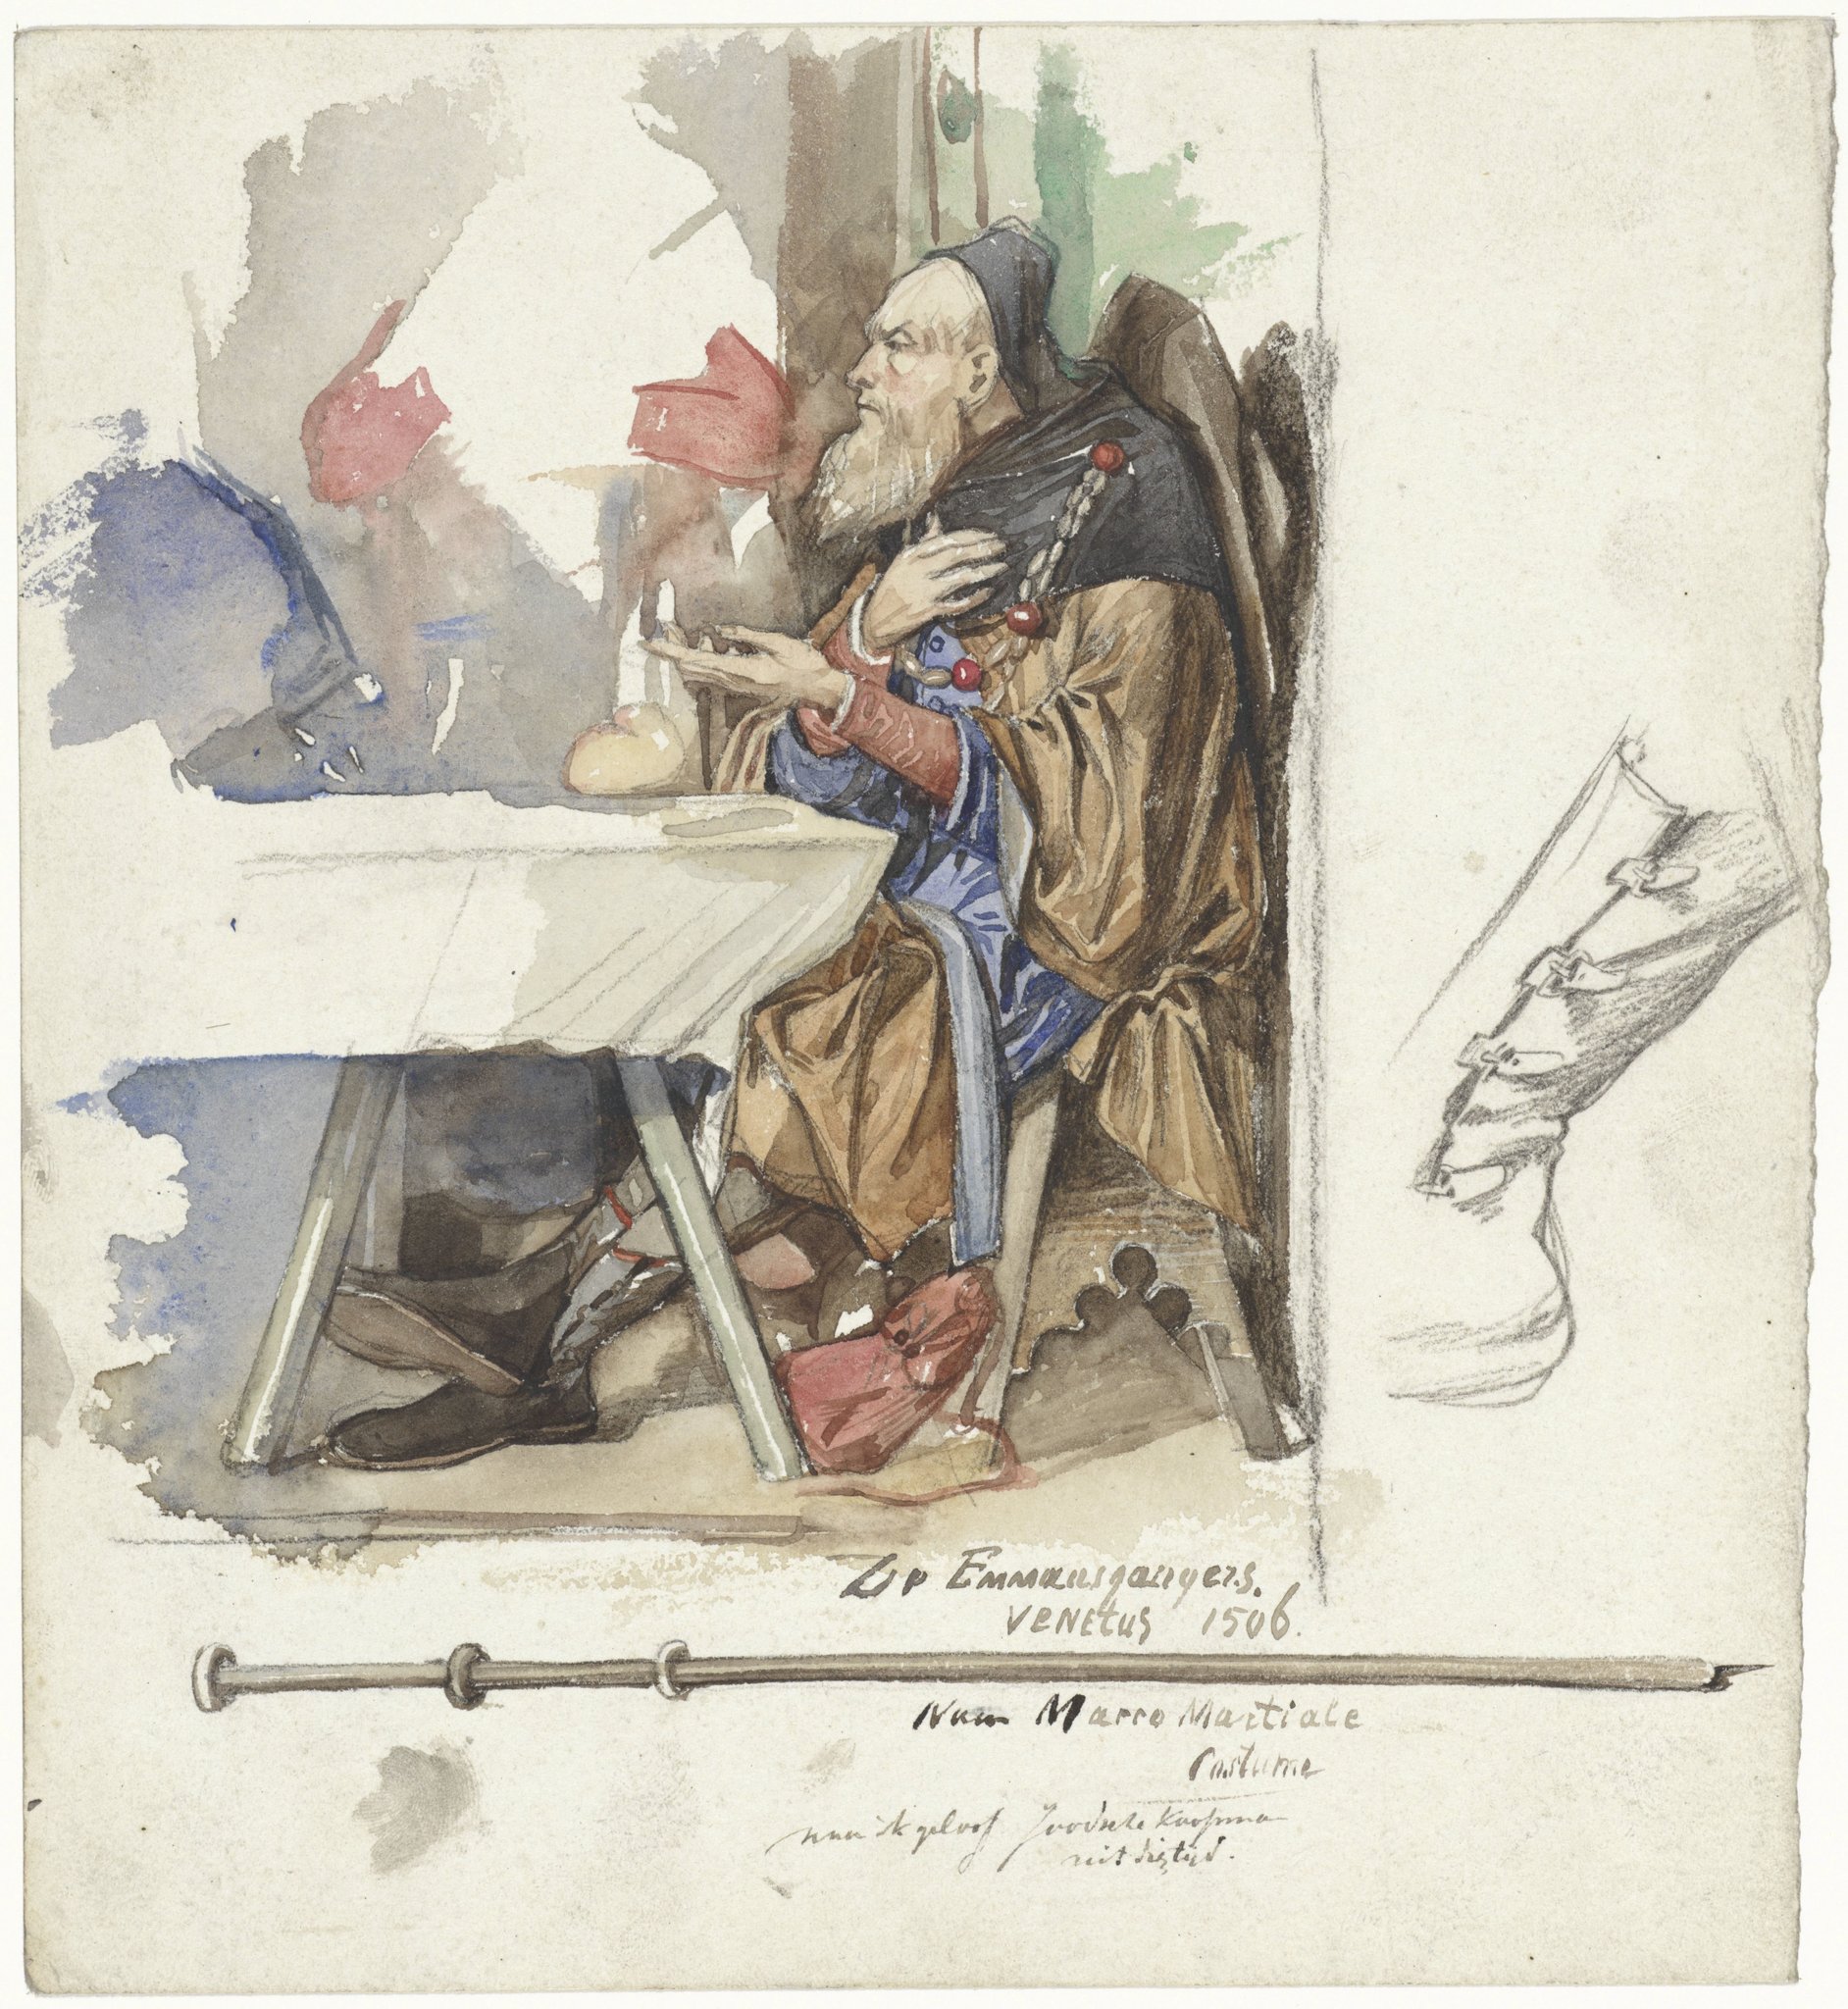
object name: watercolor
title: Detail van De Emmaüsgangers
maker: jac van looij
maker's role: draughtsman, painter, print maker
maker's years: 1855-1930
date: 1865-1930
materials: chalk, paper, watercolor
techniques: brush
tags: the supper at emmaus: christ is recognized while blessing or breaking the bread, picture, painting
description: Detail van schilderij De Emmaüsgangers van Marco Marziale.